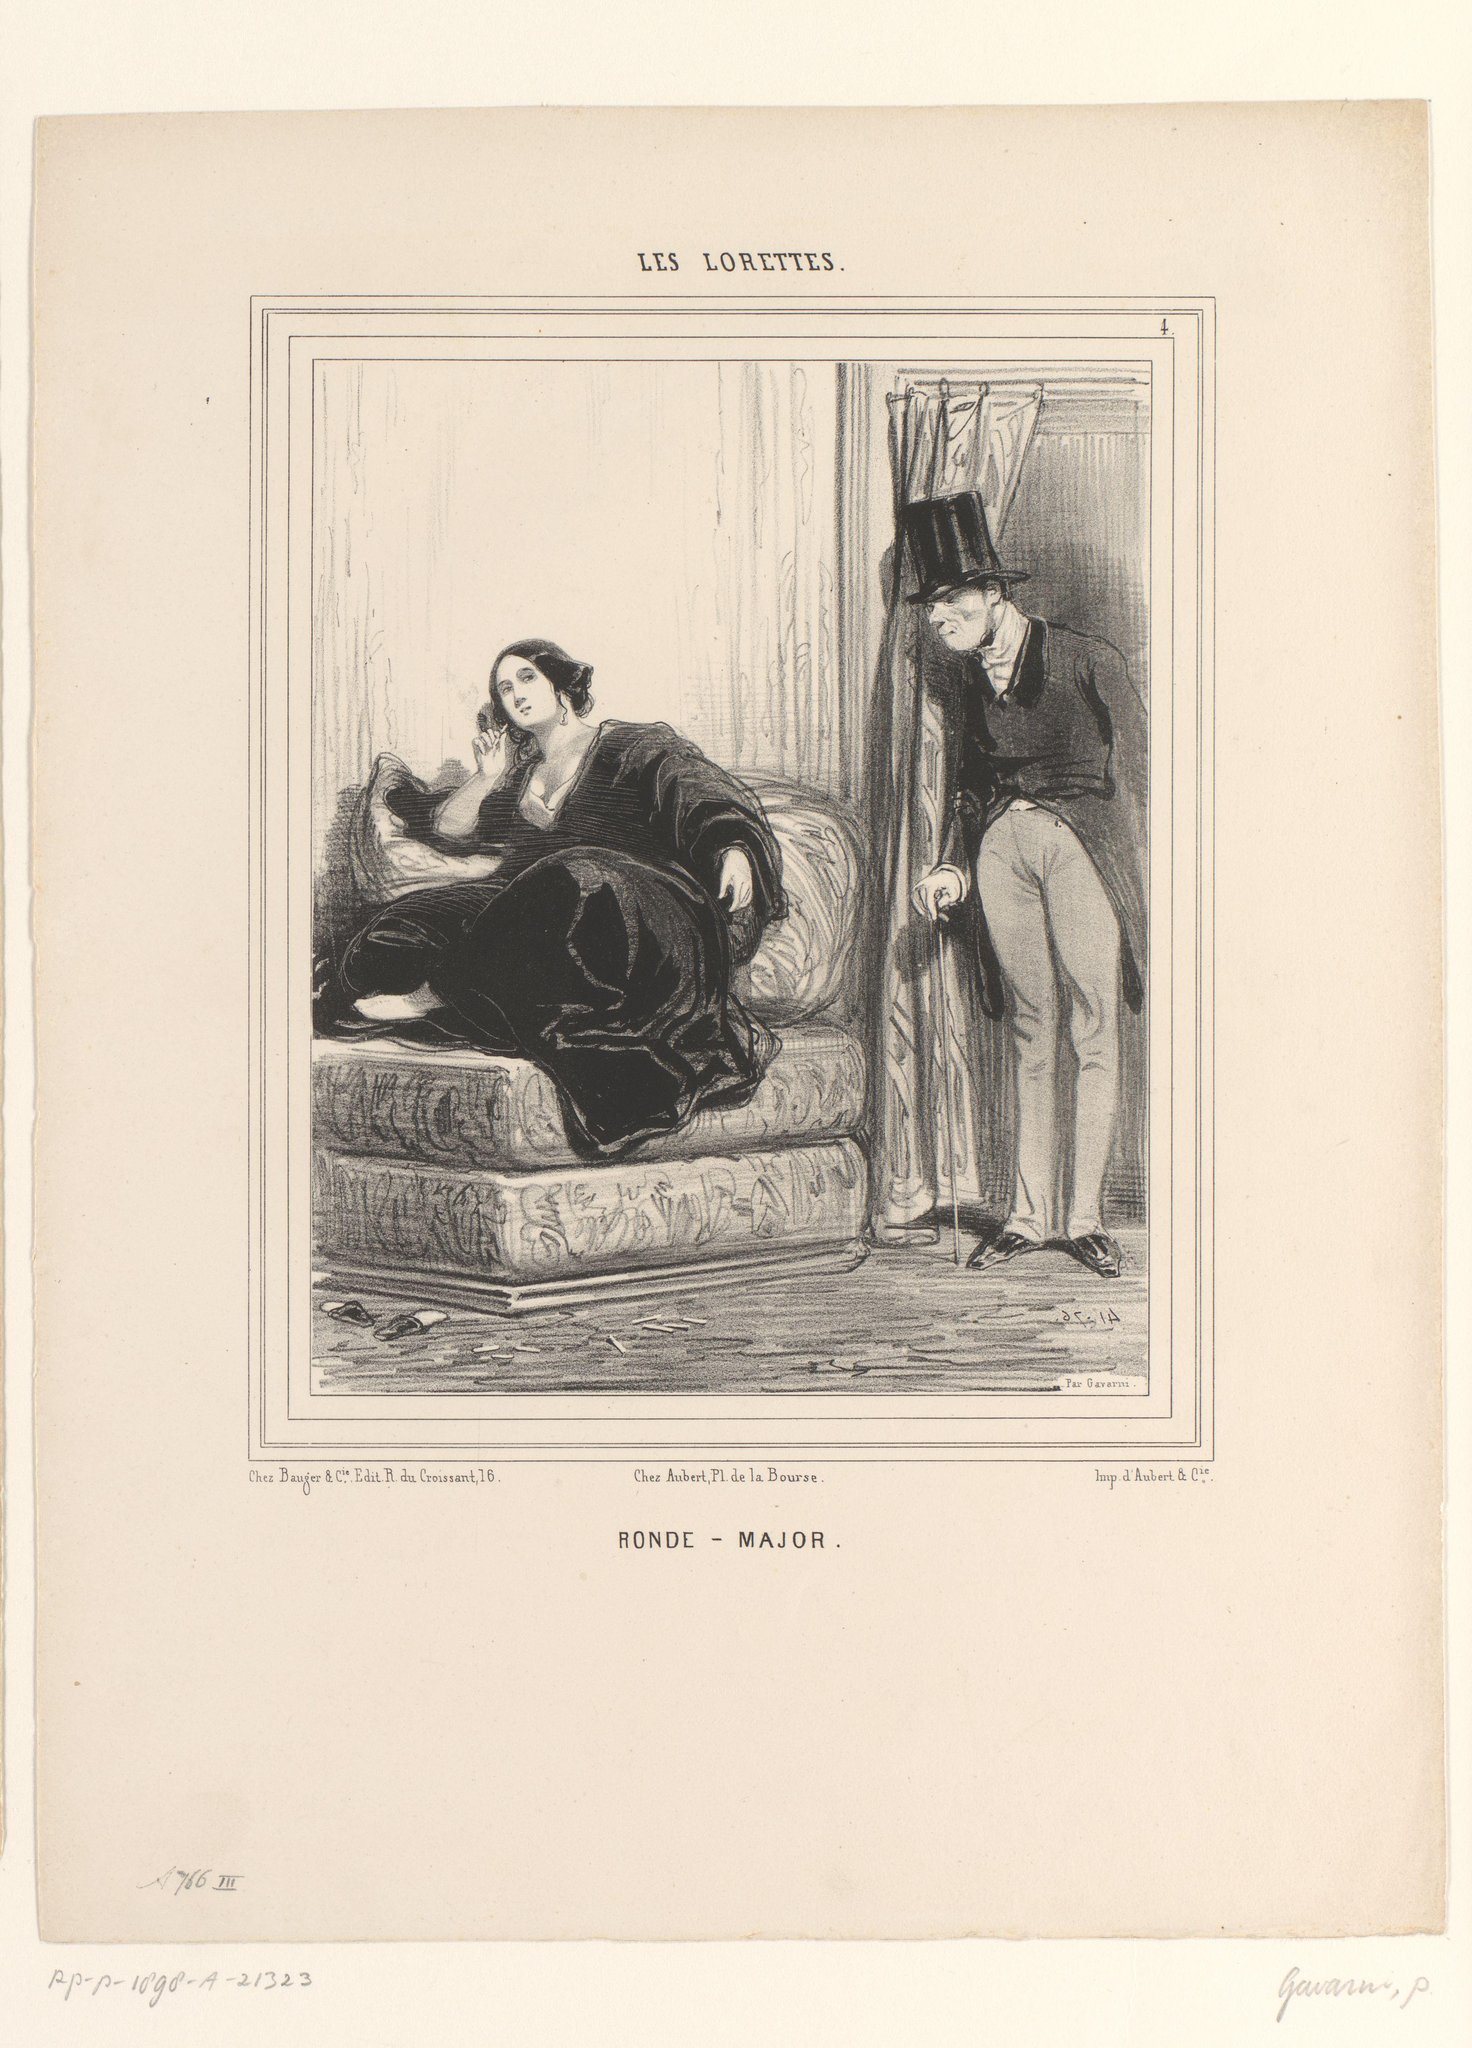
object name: cartoon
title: Vrouwen uit Notre-Dame-de-Lorette in Parijs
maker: paul gavarni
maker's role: draughtsman, print maker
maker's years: 1804-1866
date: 1841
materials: paper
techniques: lithograph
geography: paris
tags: married couple of unequal age, couch, sofa, settee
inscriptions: collector's mark: Lugt 964, check stamp: Lugt 3855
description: Prent gebruikt voor: Le Charivari, 26 september 1841.